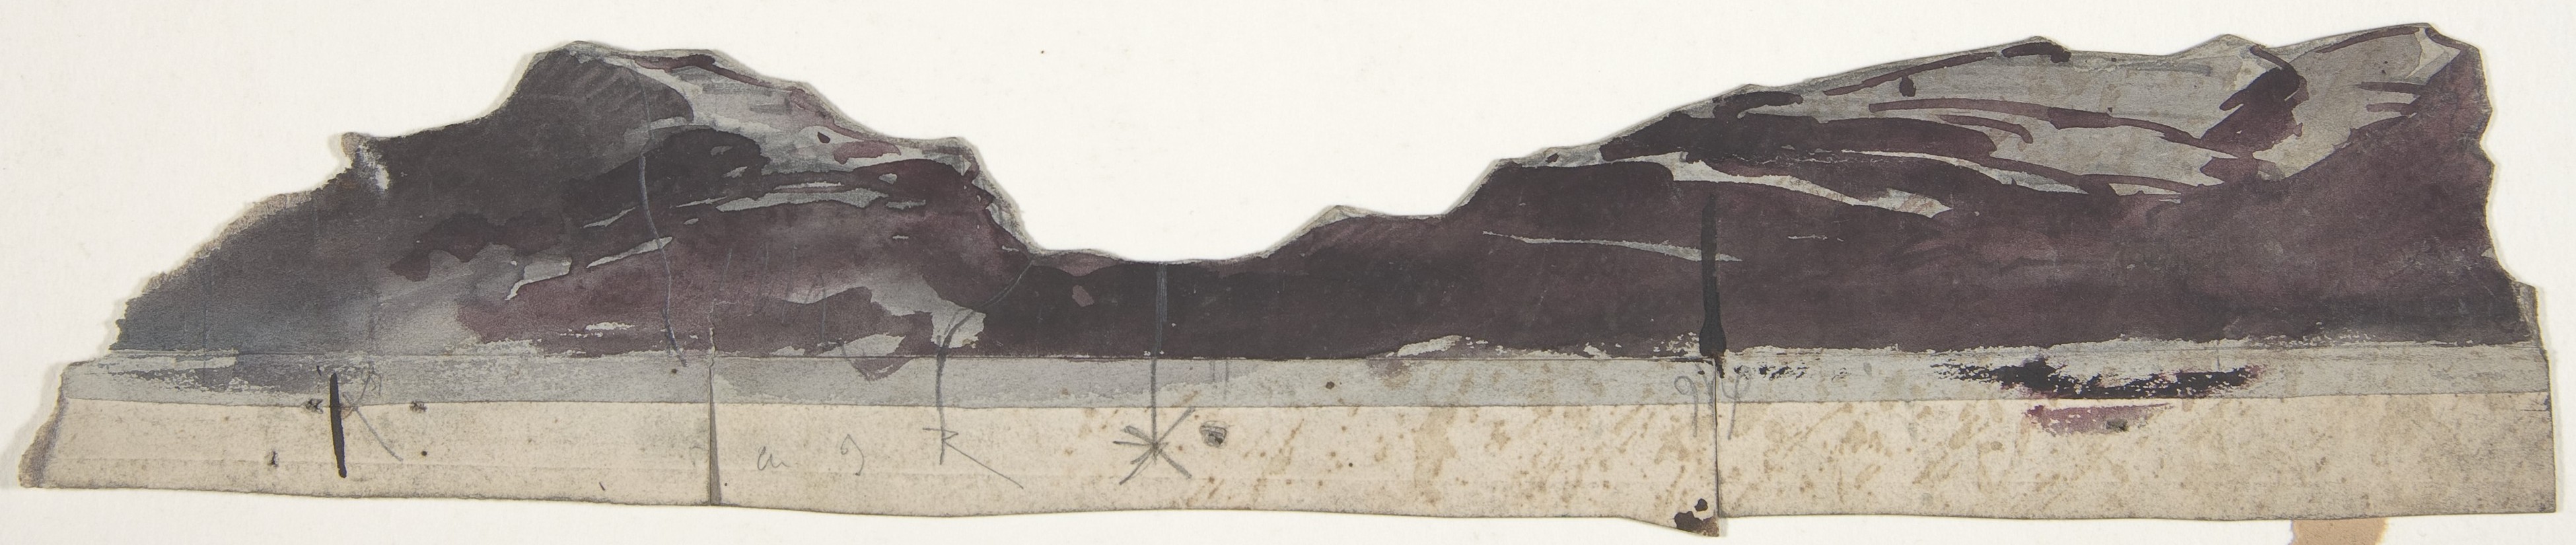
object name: drawing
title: Design for a Stage Set at the Opéra, Paris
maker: eugène cicéri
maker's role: artist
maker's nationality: french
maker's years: 1813-1890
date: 1830-1890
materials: graphite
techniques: brush, wash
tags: stage design